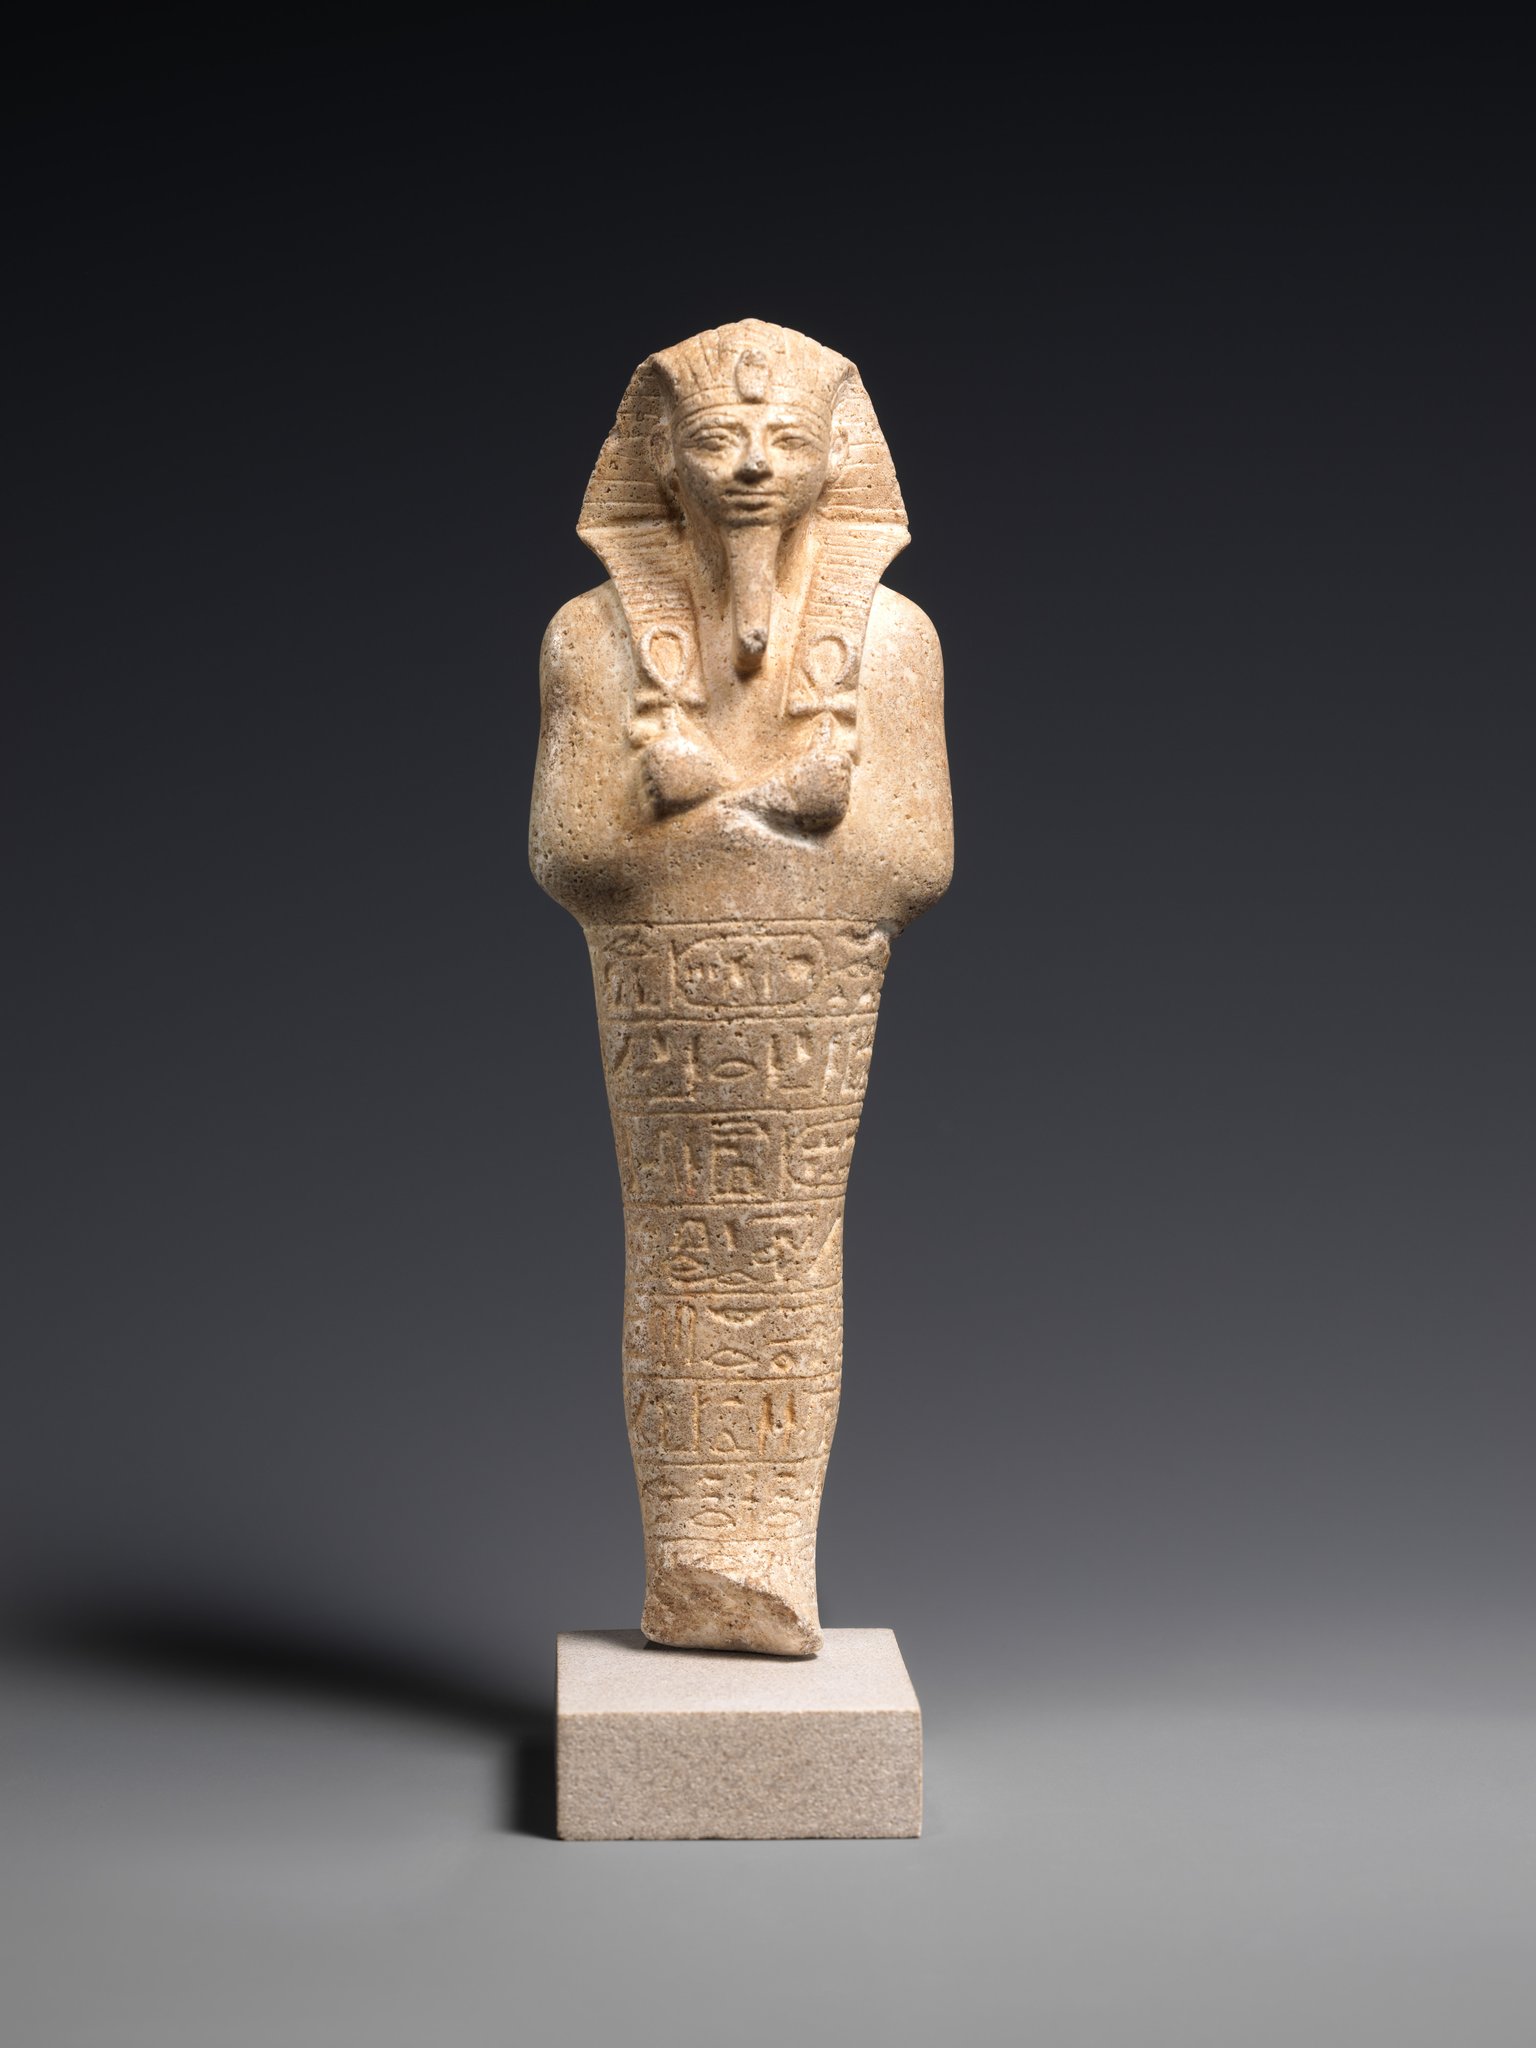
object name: shabti, amenhotep ii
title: Shabti of Amenhotep II Holding Two Ankhs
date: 1427-1400 BCE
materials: limestone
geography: egypt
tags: hieroglyphs